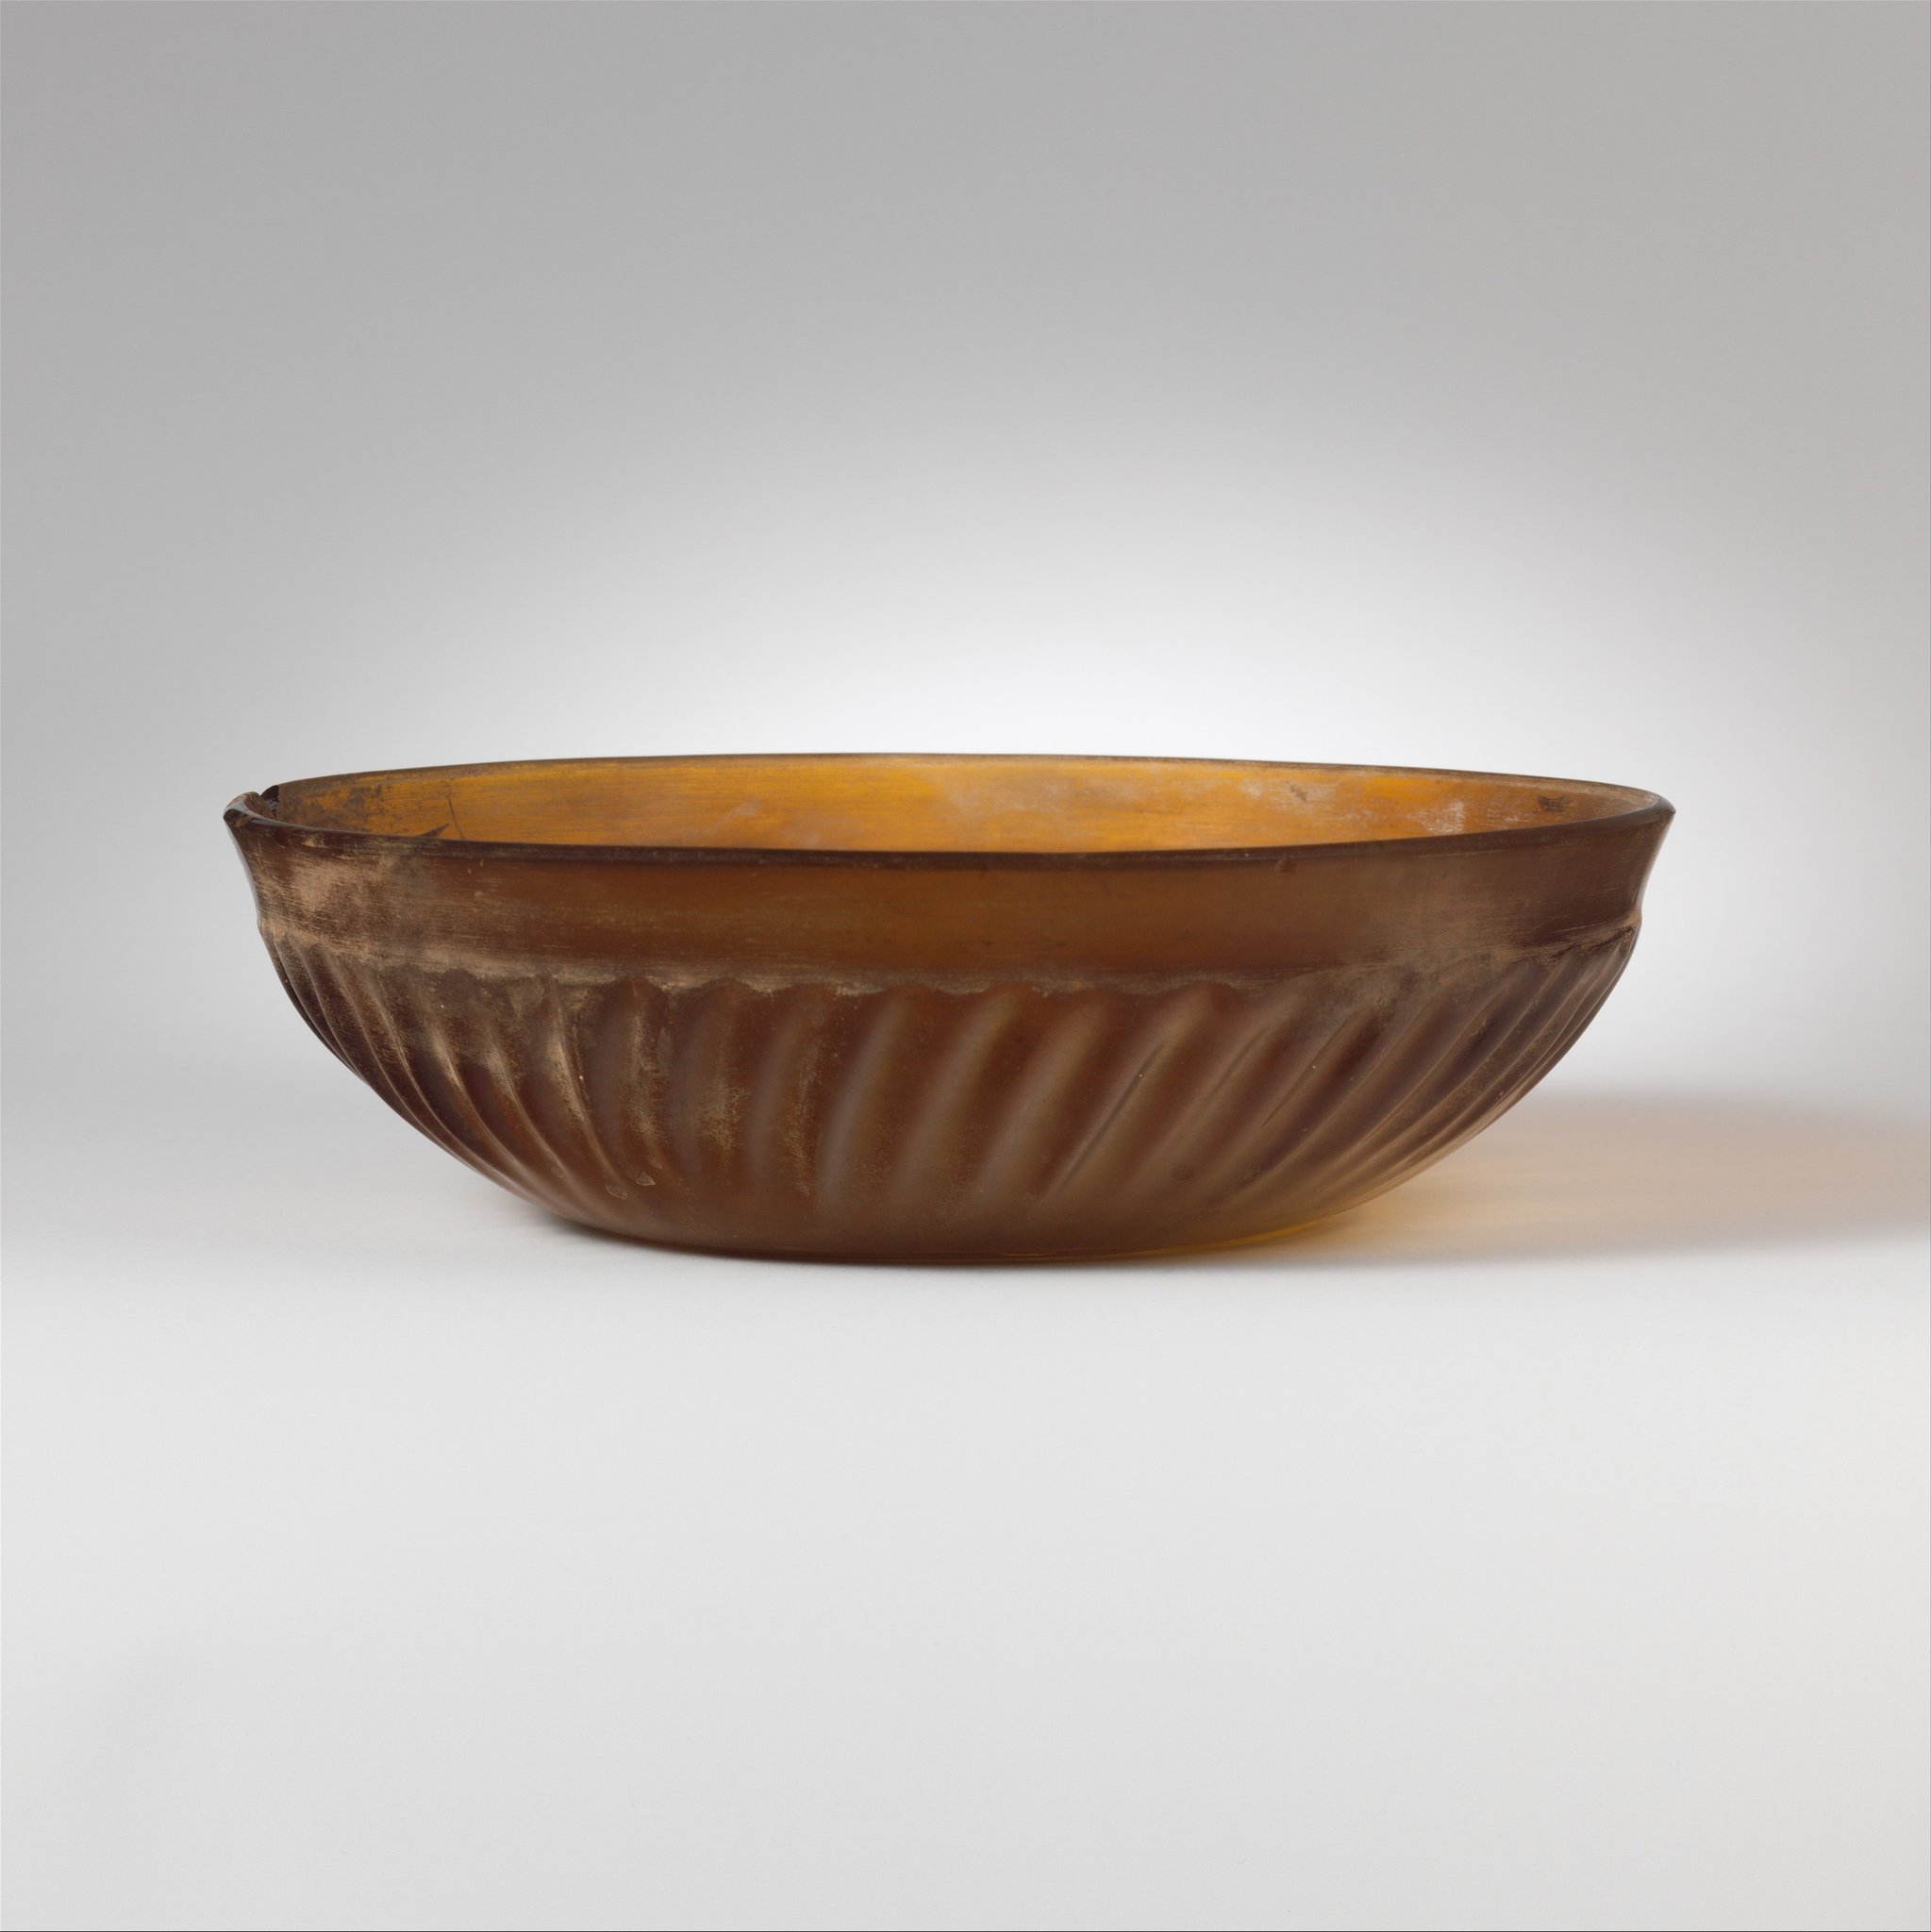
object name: bowl, ribbed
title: Glass ribbed bowl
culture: roman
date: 67-100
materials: glass